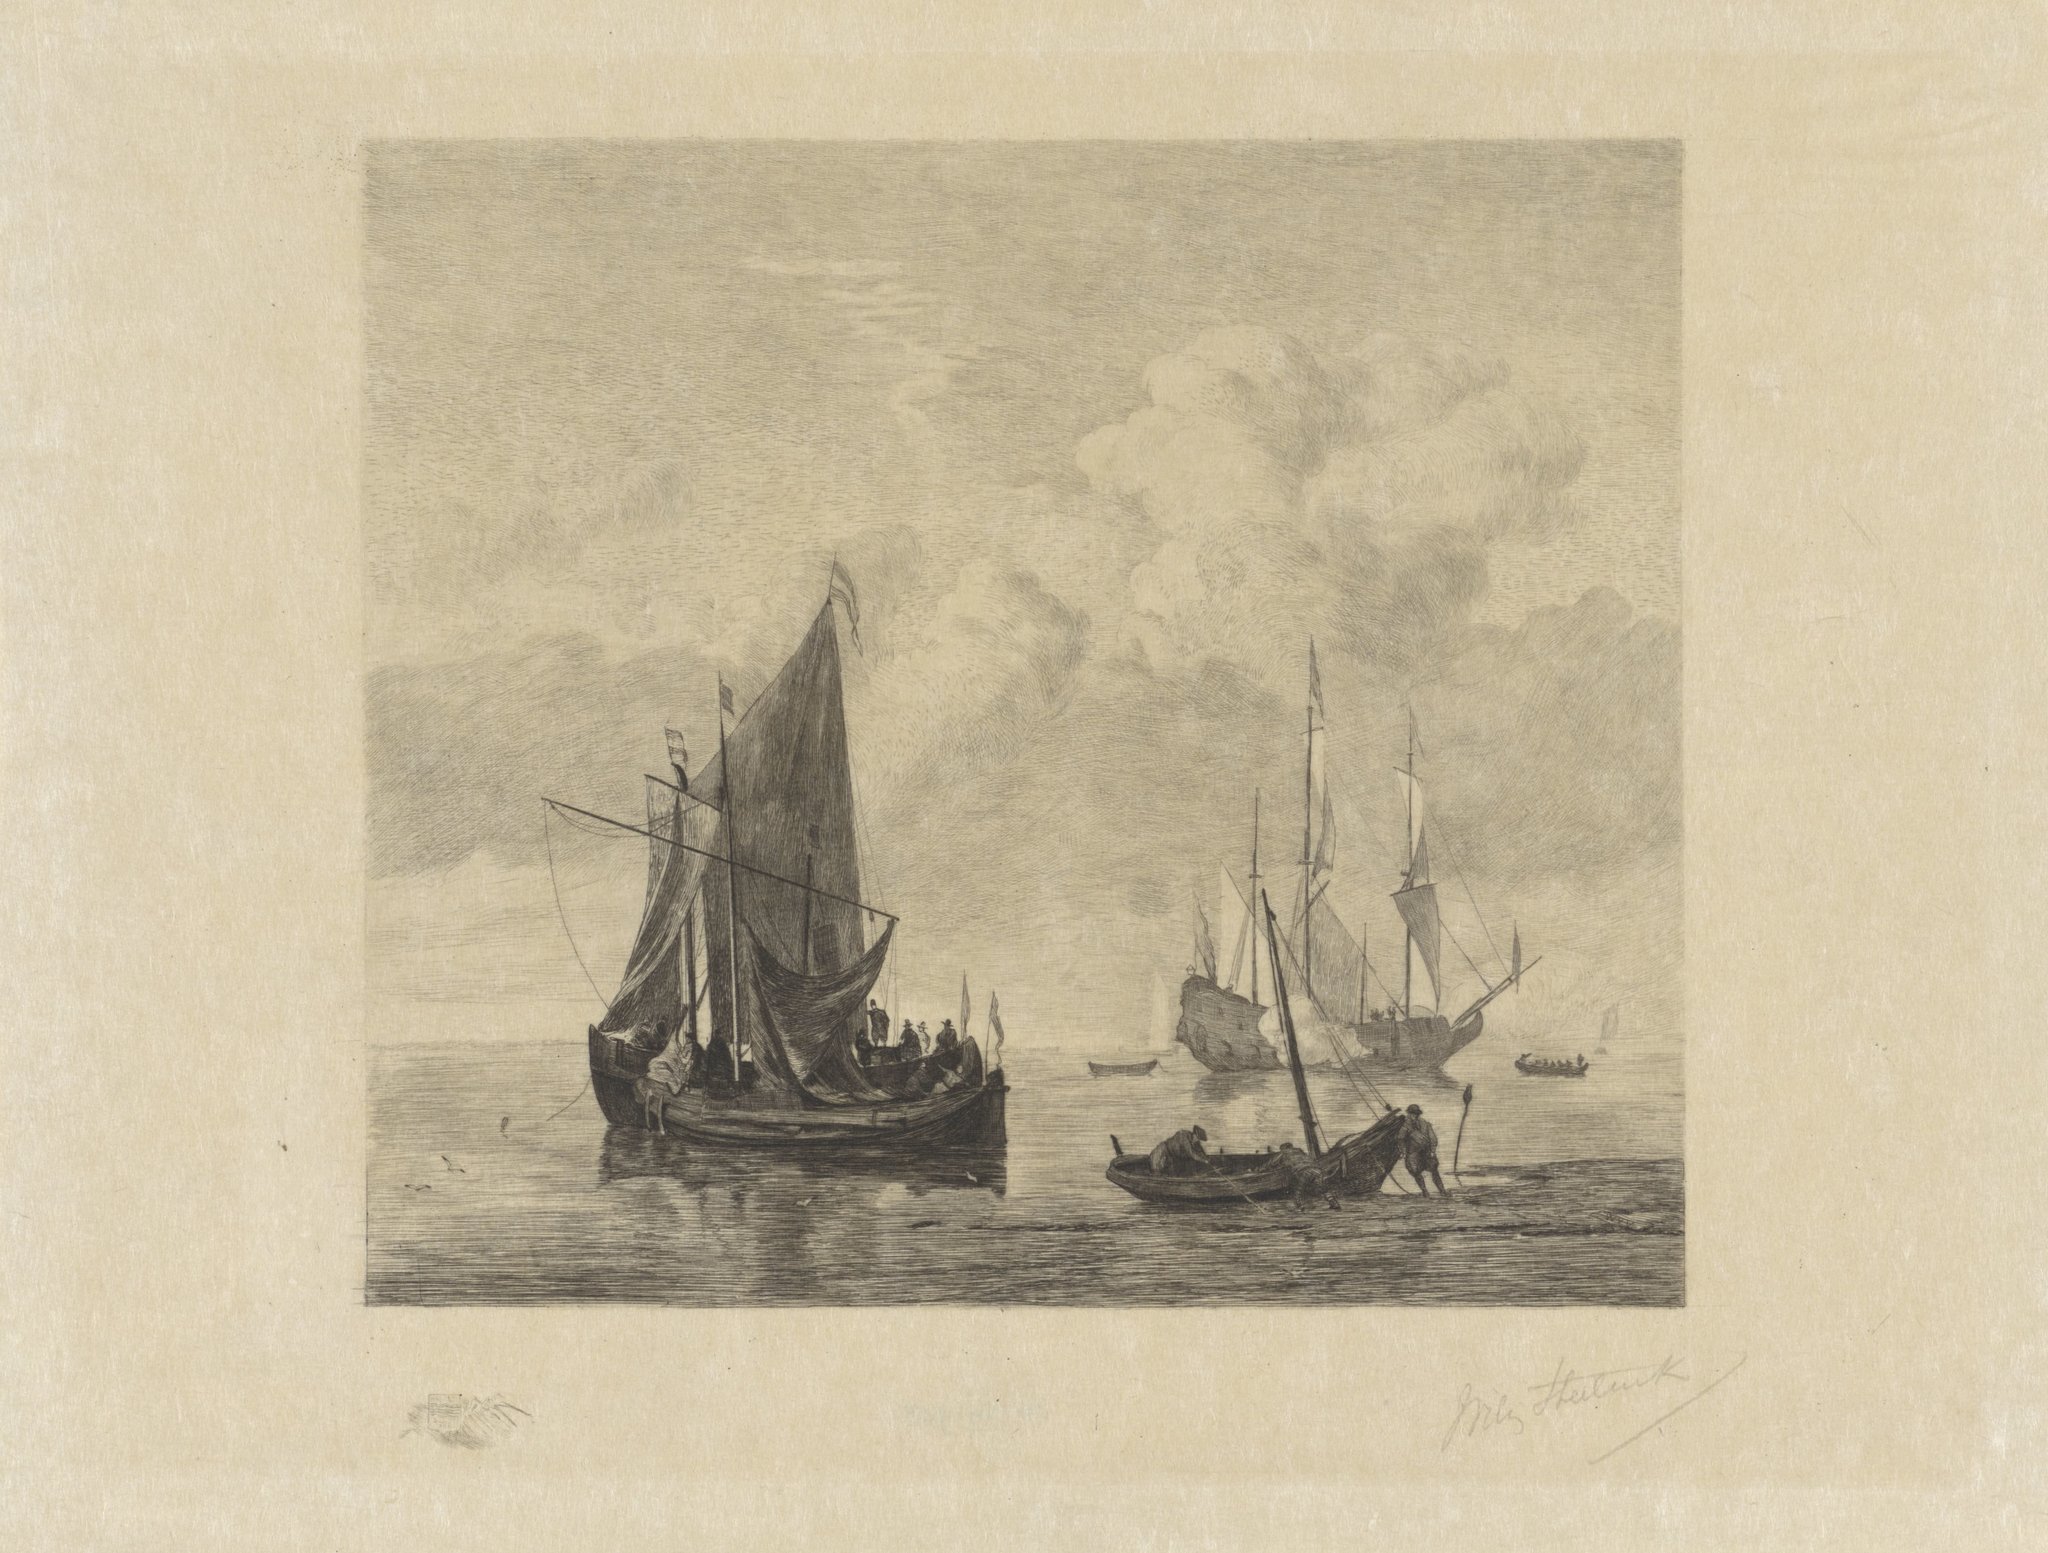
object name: print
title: Zeilschepen op kalme zee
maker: willem steelink (ii)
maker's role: draughtsman, print maker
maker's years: 1856-1928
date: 1888-1891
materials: paper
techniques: etching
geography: netherlands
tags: sailing-ship, sailing-boat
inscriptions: collector's mark: Lugt 2228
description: Enkele schepen voor de kust op een gladde zee. Op de voorgrond enkele figuren bij een aangemeerde boot. Linksonder in de marge een wapenschild op een takje met bladeren.